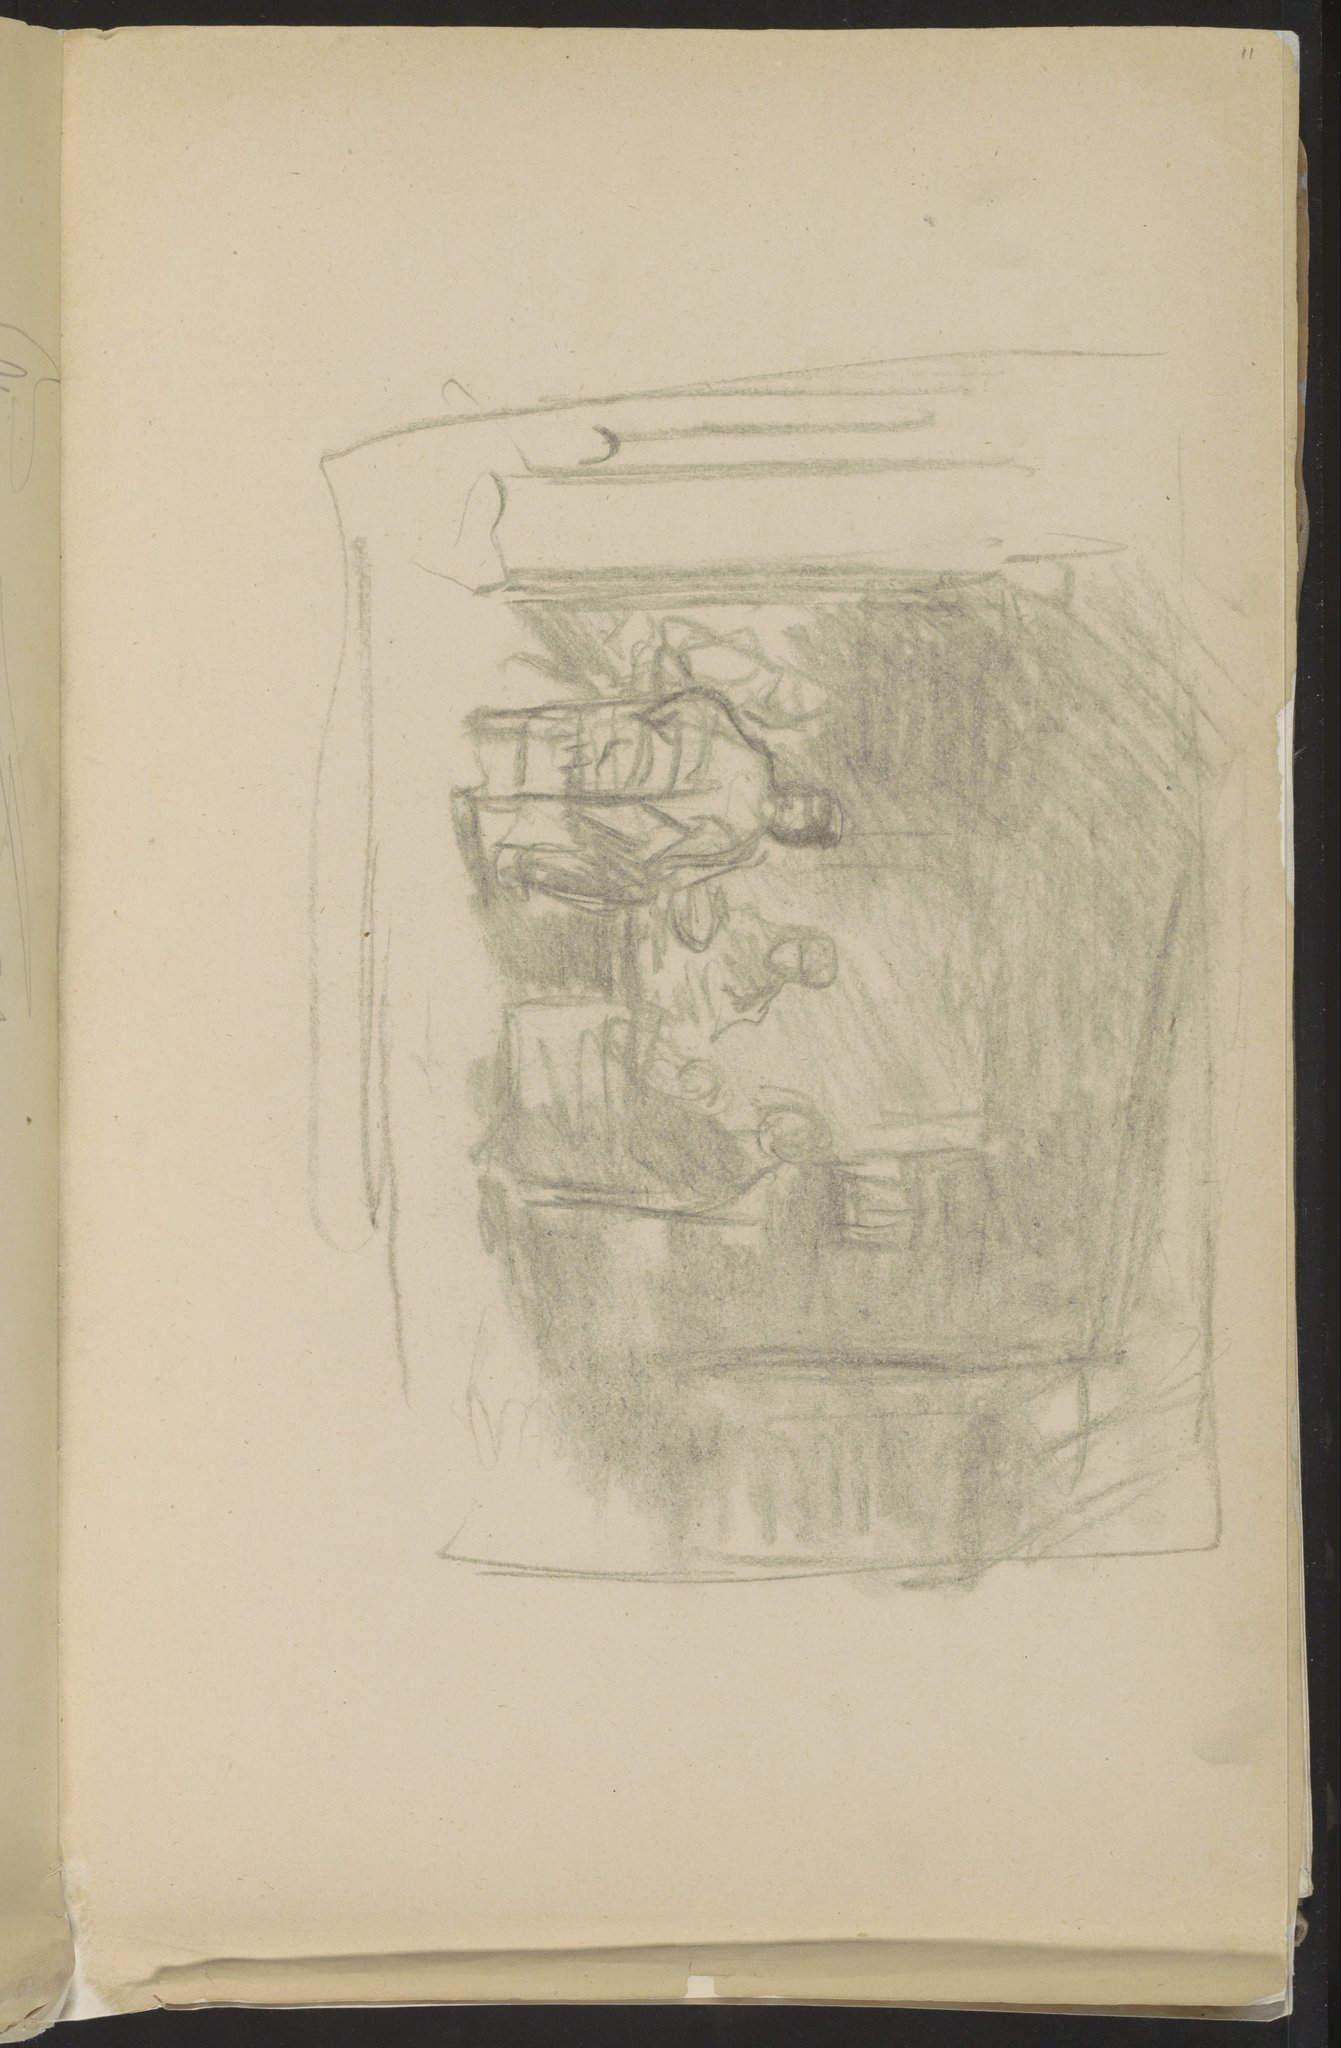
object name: sketchbook leaf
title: Boereninterieur met een gezin aan de maaltijd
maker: albert neuhuys (1844-1914)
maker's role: draughtsman, painter, print maker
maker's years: 1844-1914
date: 1854-1914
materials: charcoal, paper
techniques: stumping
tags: table, interior of the house, (family) meal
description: Blad 11 recto uit een schetsboek met 53 bladen.